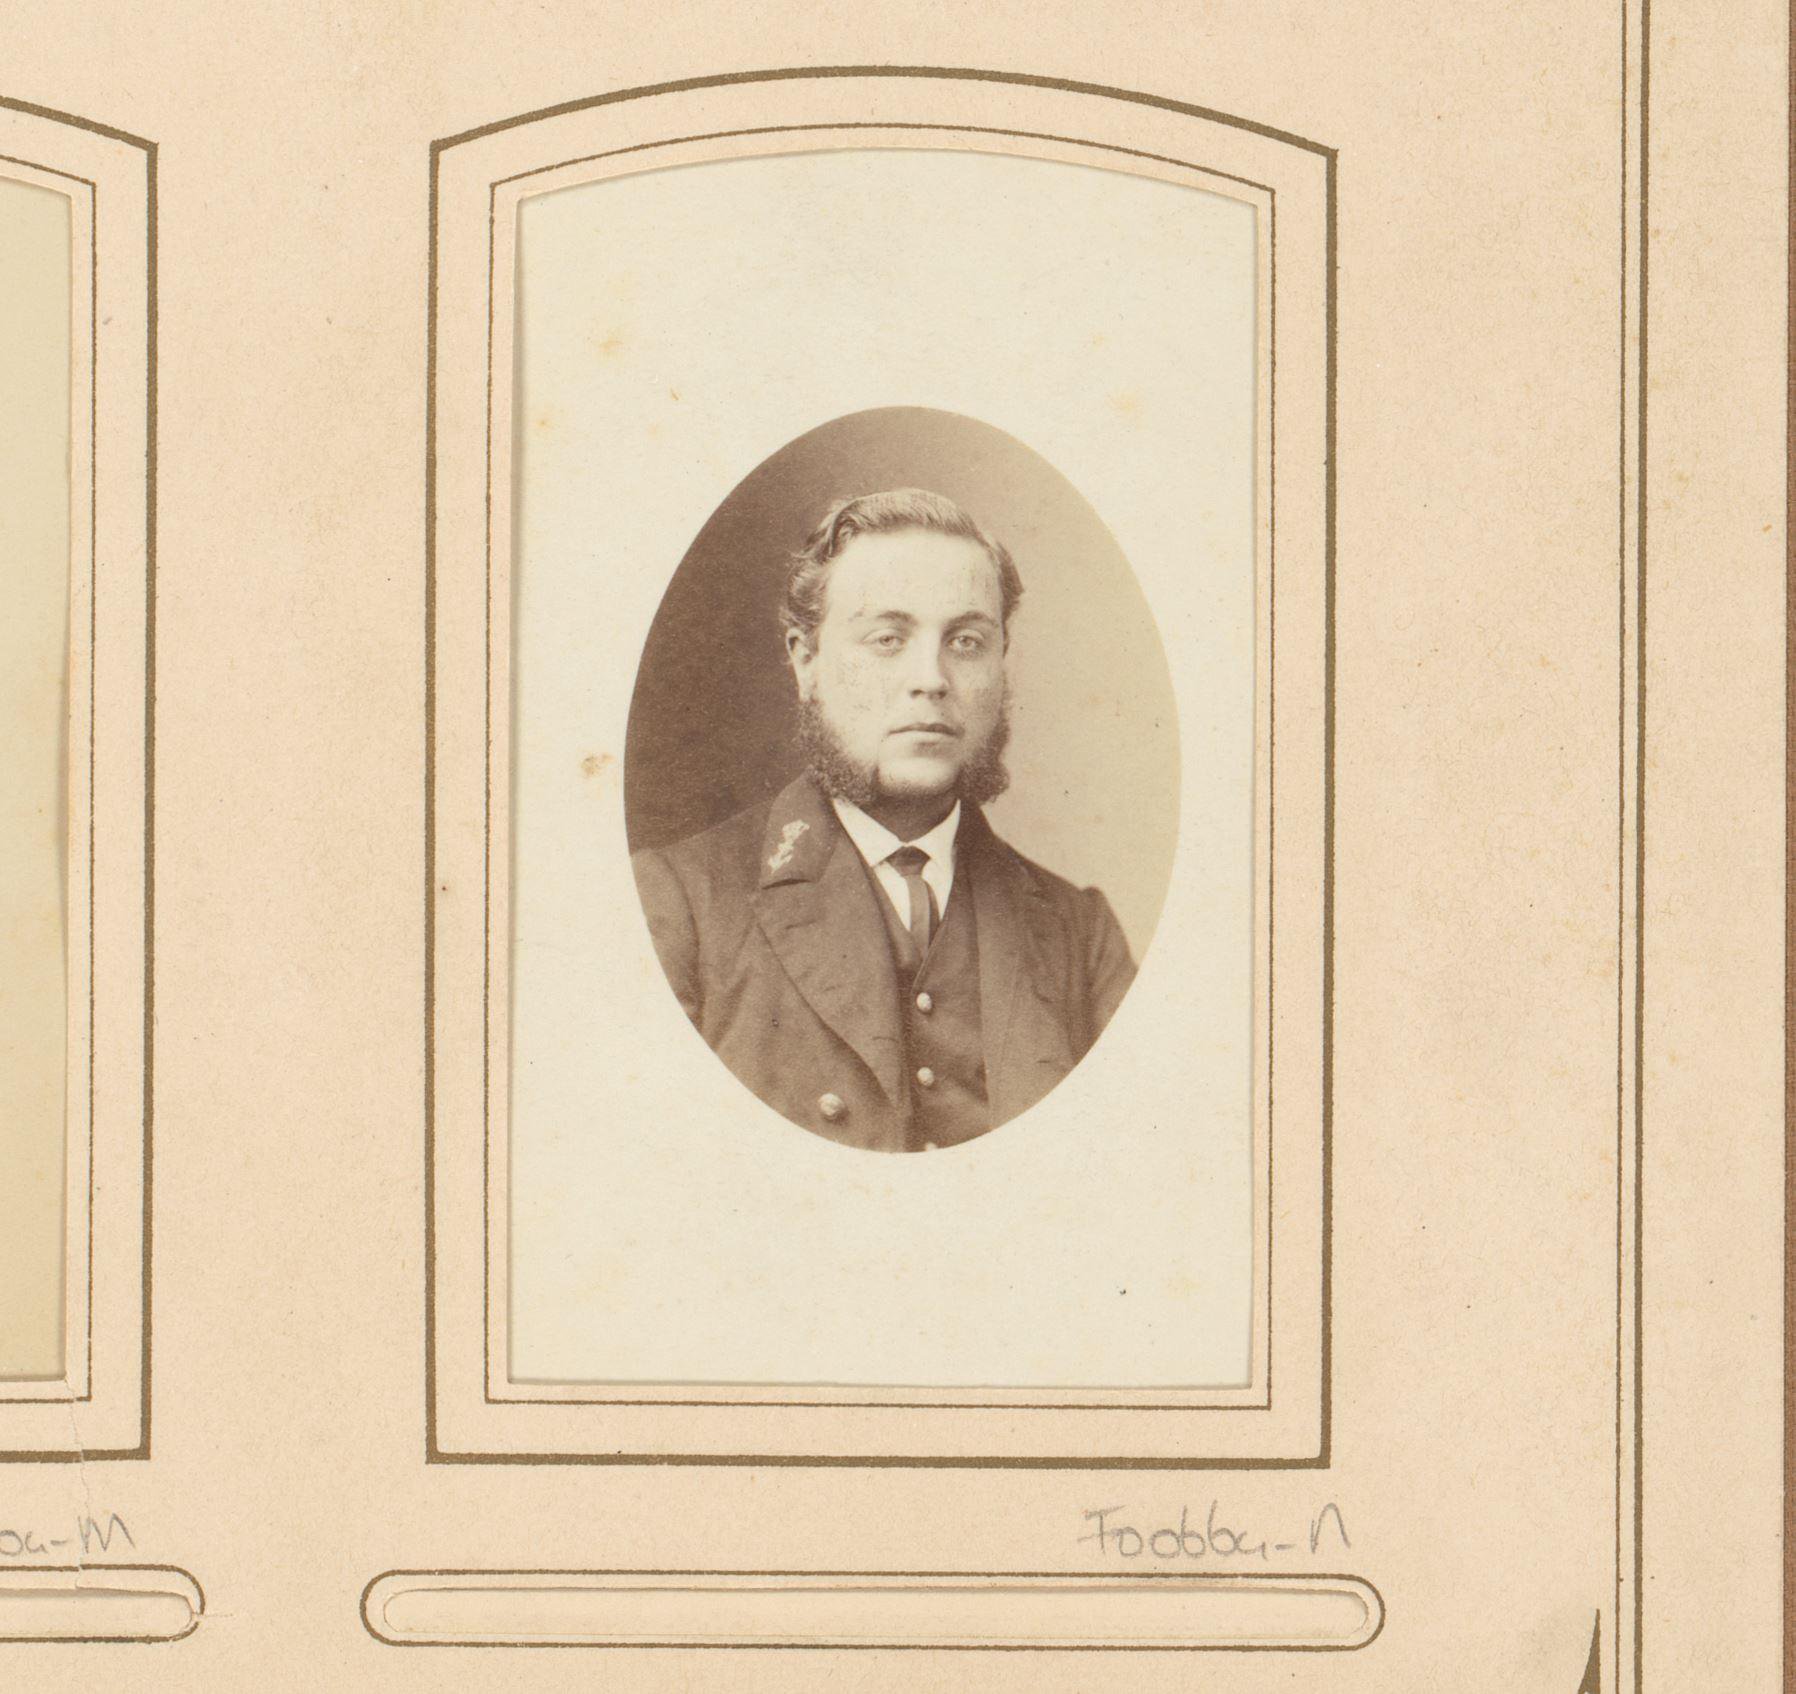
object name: album leaf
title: Portret van G.H. Gregory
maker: david scott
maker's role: fotograaf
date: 1810-1871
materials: cardboard, photographic support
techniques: albumen print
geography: sydney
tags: historical persons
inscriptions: annotation: ‘G.H. Gregory/ Curaçao Oct. 1871’, inscription: ‘David Scott, Successor/ W. Bradley 140. Pitt st. Sydney’